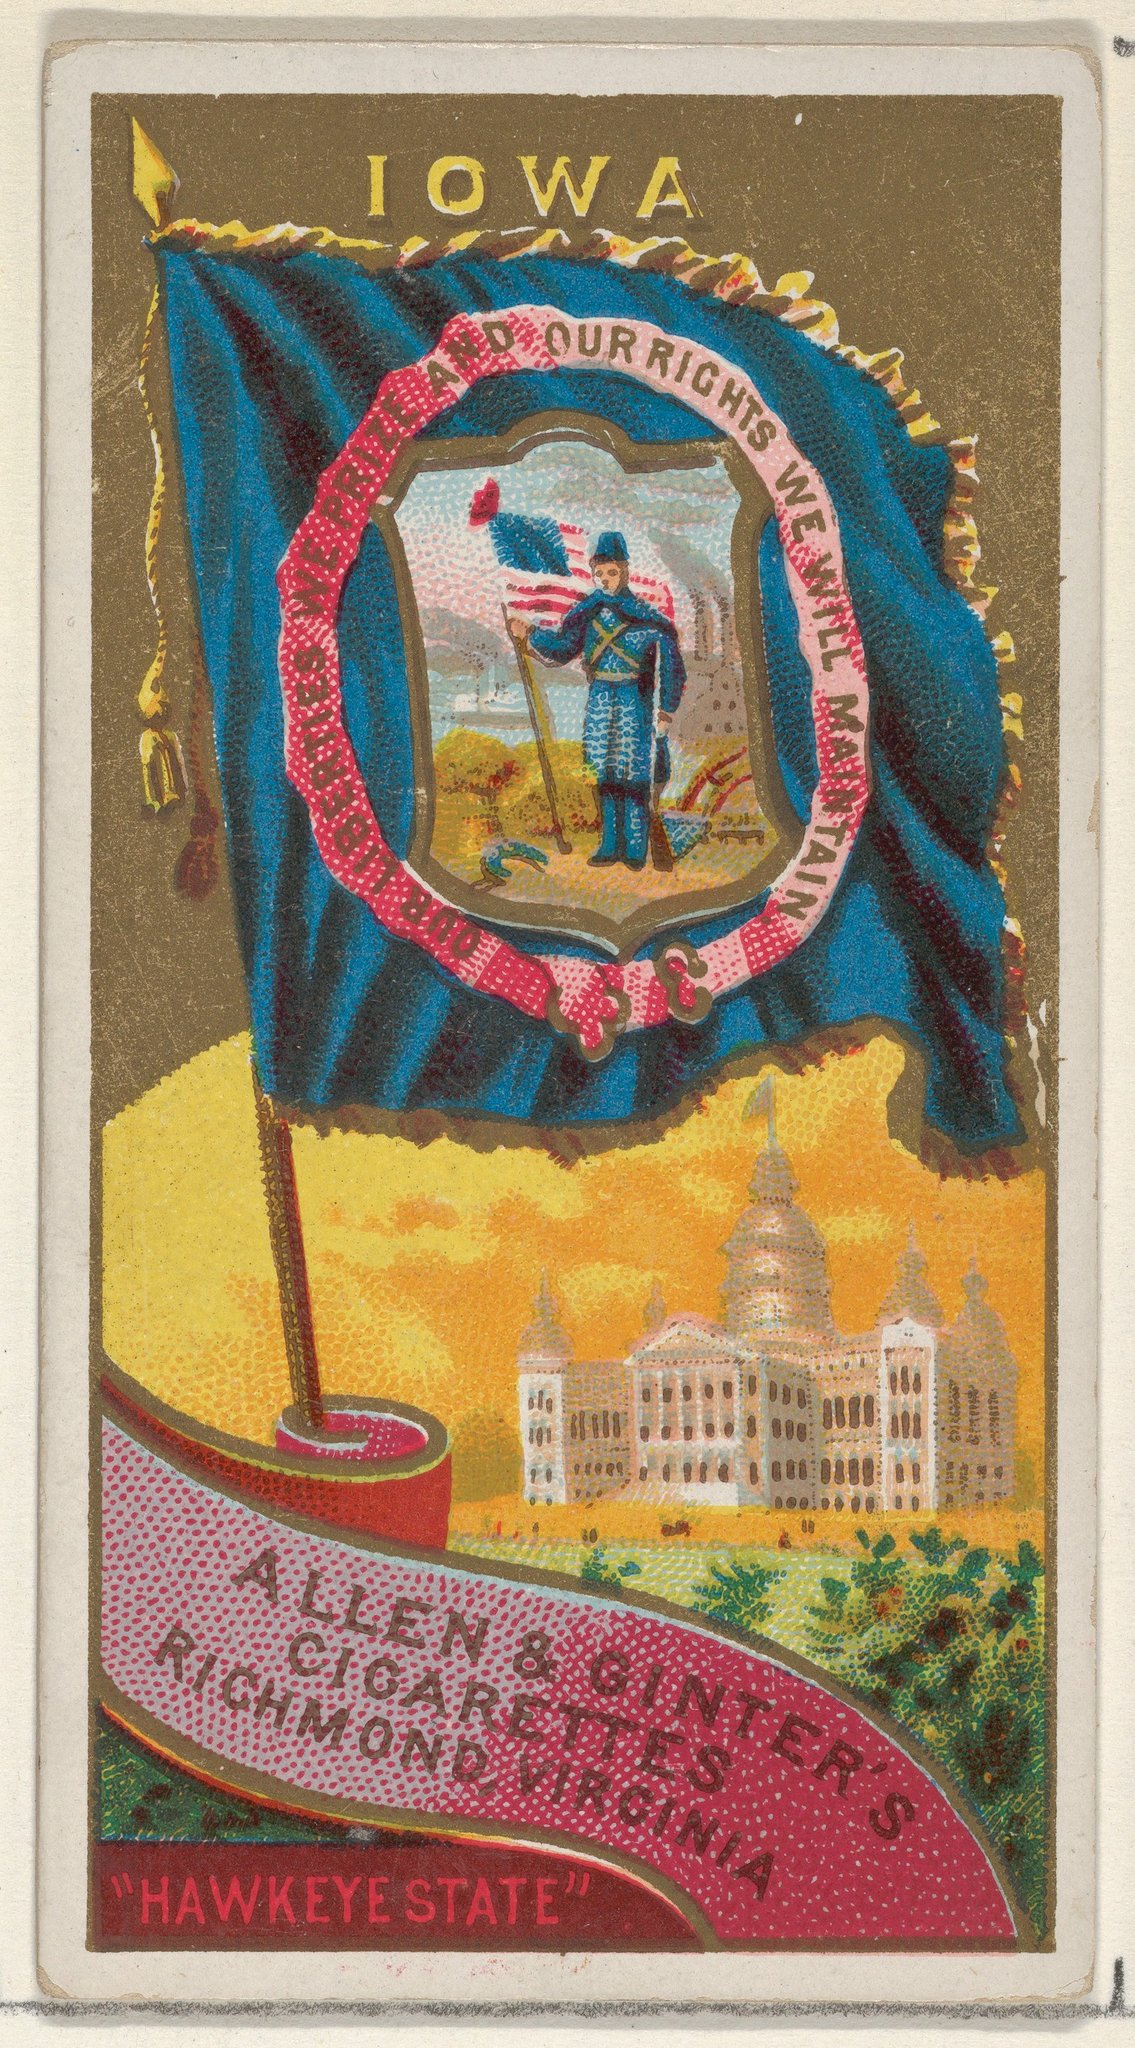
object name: print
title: Iowa, from Flags of the States and Territories (N11) for Allen & Ginter Cigarettes Brands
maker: allen & ginter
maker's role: publisher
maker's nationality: american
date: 1888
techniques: color lithograph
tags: flags